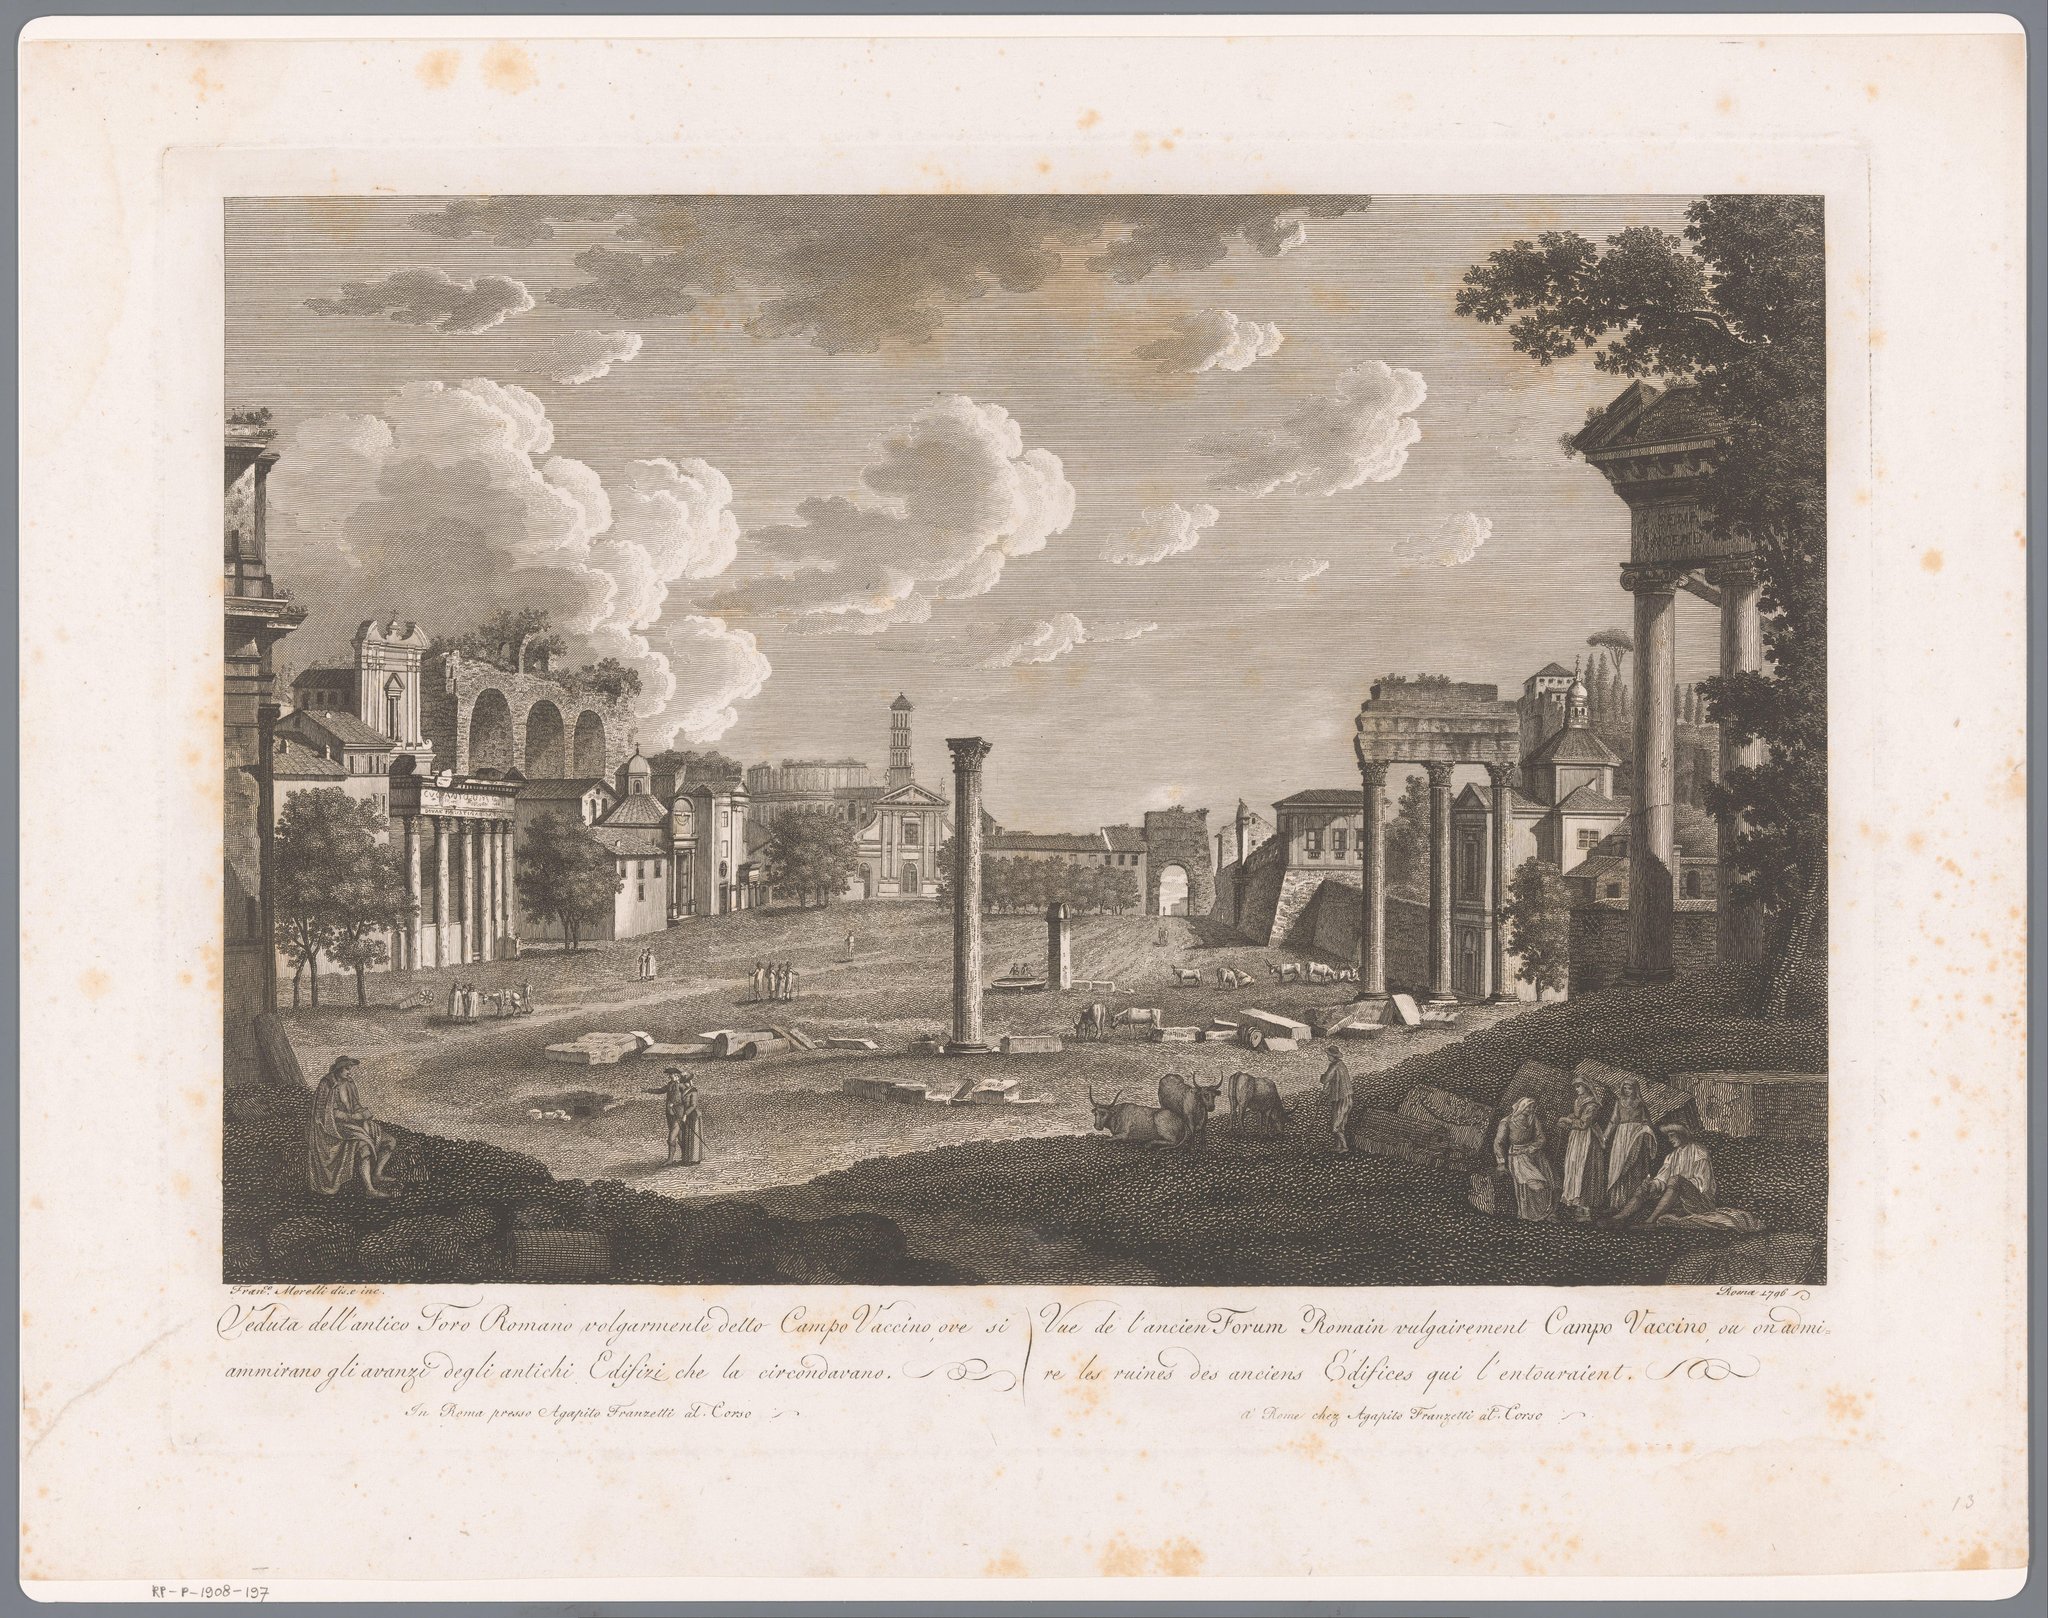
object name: print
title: Gezicht op het Forum Romanum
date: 1796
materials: paper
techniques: etching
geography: rome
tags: ruin of a building ~ architecture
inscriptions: collector's mark: Lugt 2228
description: Maakt deel uit van een serie met gezichten op Rome.